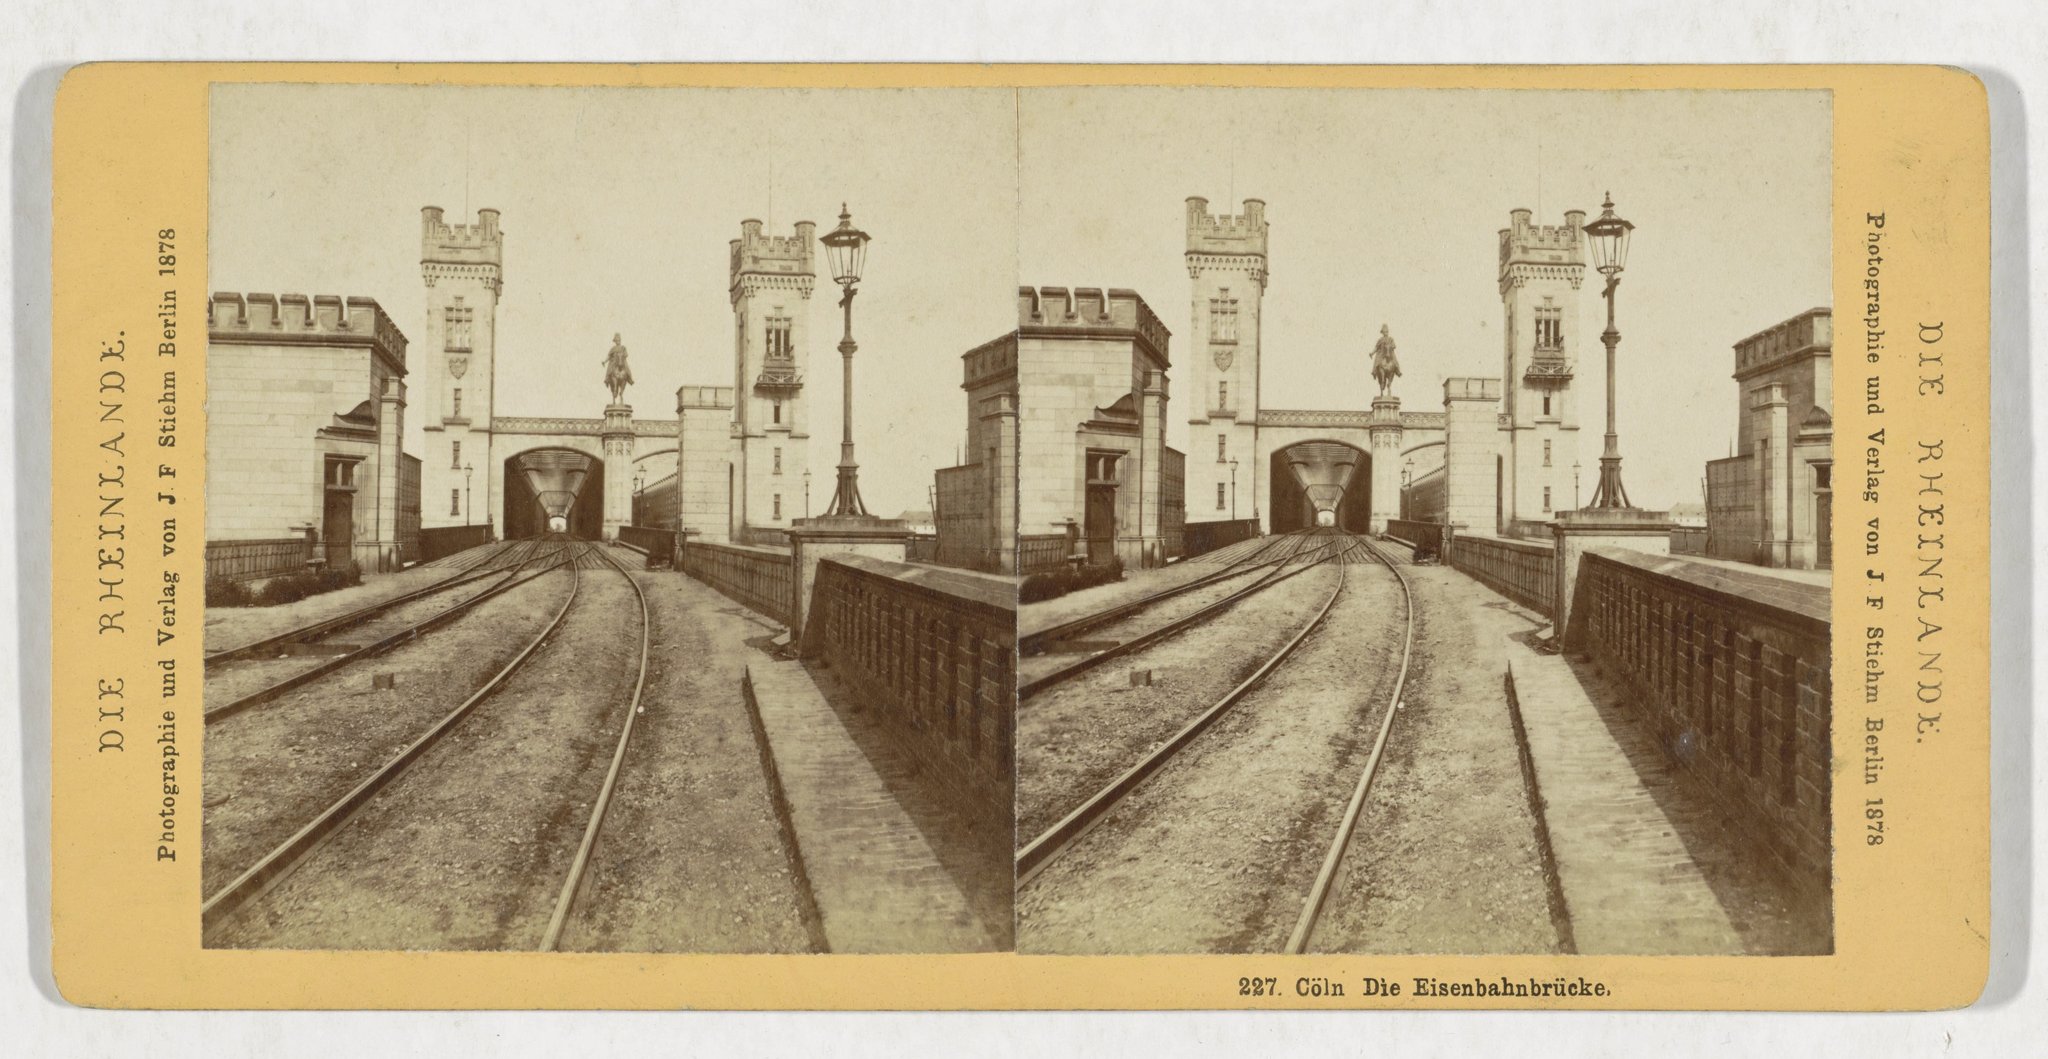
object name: stereograph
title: Dombrücke in Keulen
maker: johann friedrich stiehm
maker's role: fotograaf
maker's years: 1826-1902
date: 1878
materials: cardboard, paper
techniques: albumen print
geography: berlin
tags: railway, train, bridge, cologne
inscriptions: number: ‘227.’